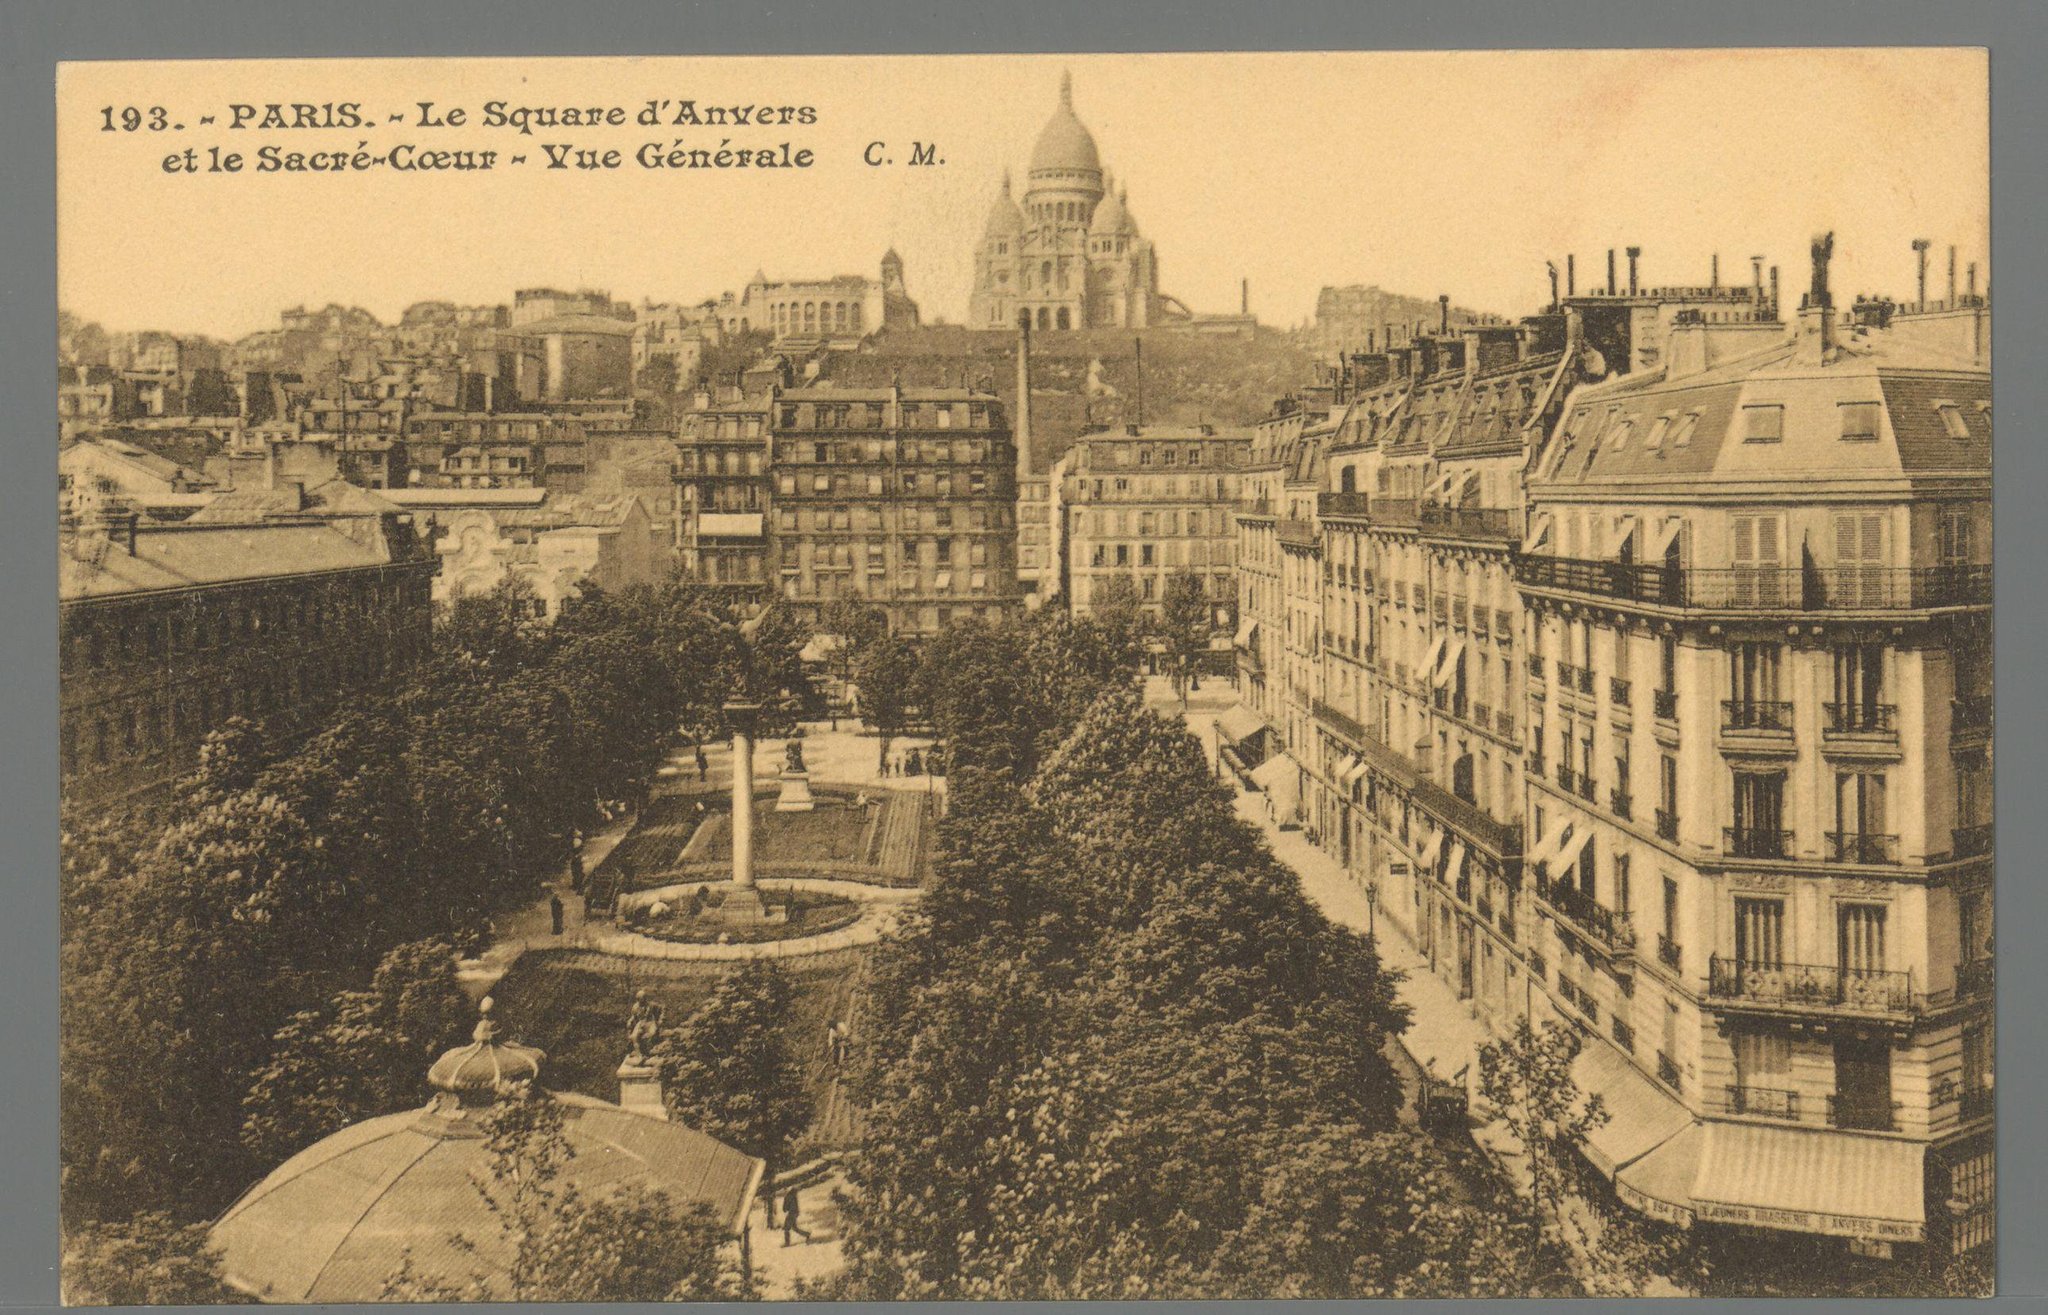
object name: ansichtkaart, prentbriefkaart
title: Paris. Le Square d'Anvers et le Sacré-Coeur. Vue Générale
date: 1903-1920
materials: cardboard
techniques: photograph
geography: paris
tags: church (exterior), city-view, and landscape with man-made constructions (+ city(-scape) with figures, staffage), public gardens, park, paris